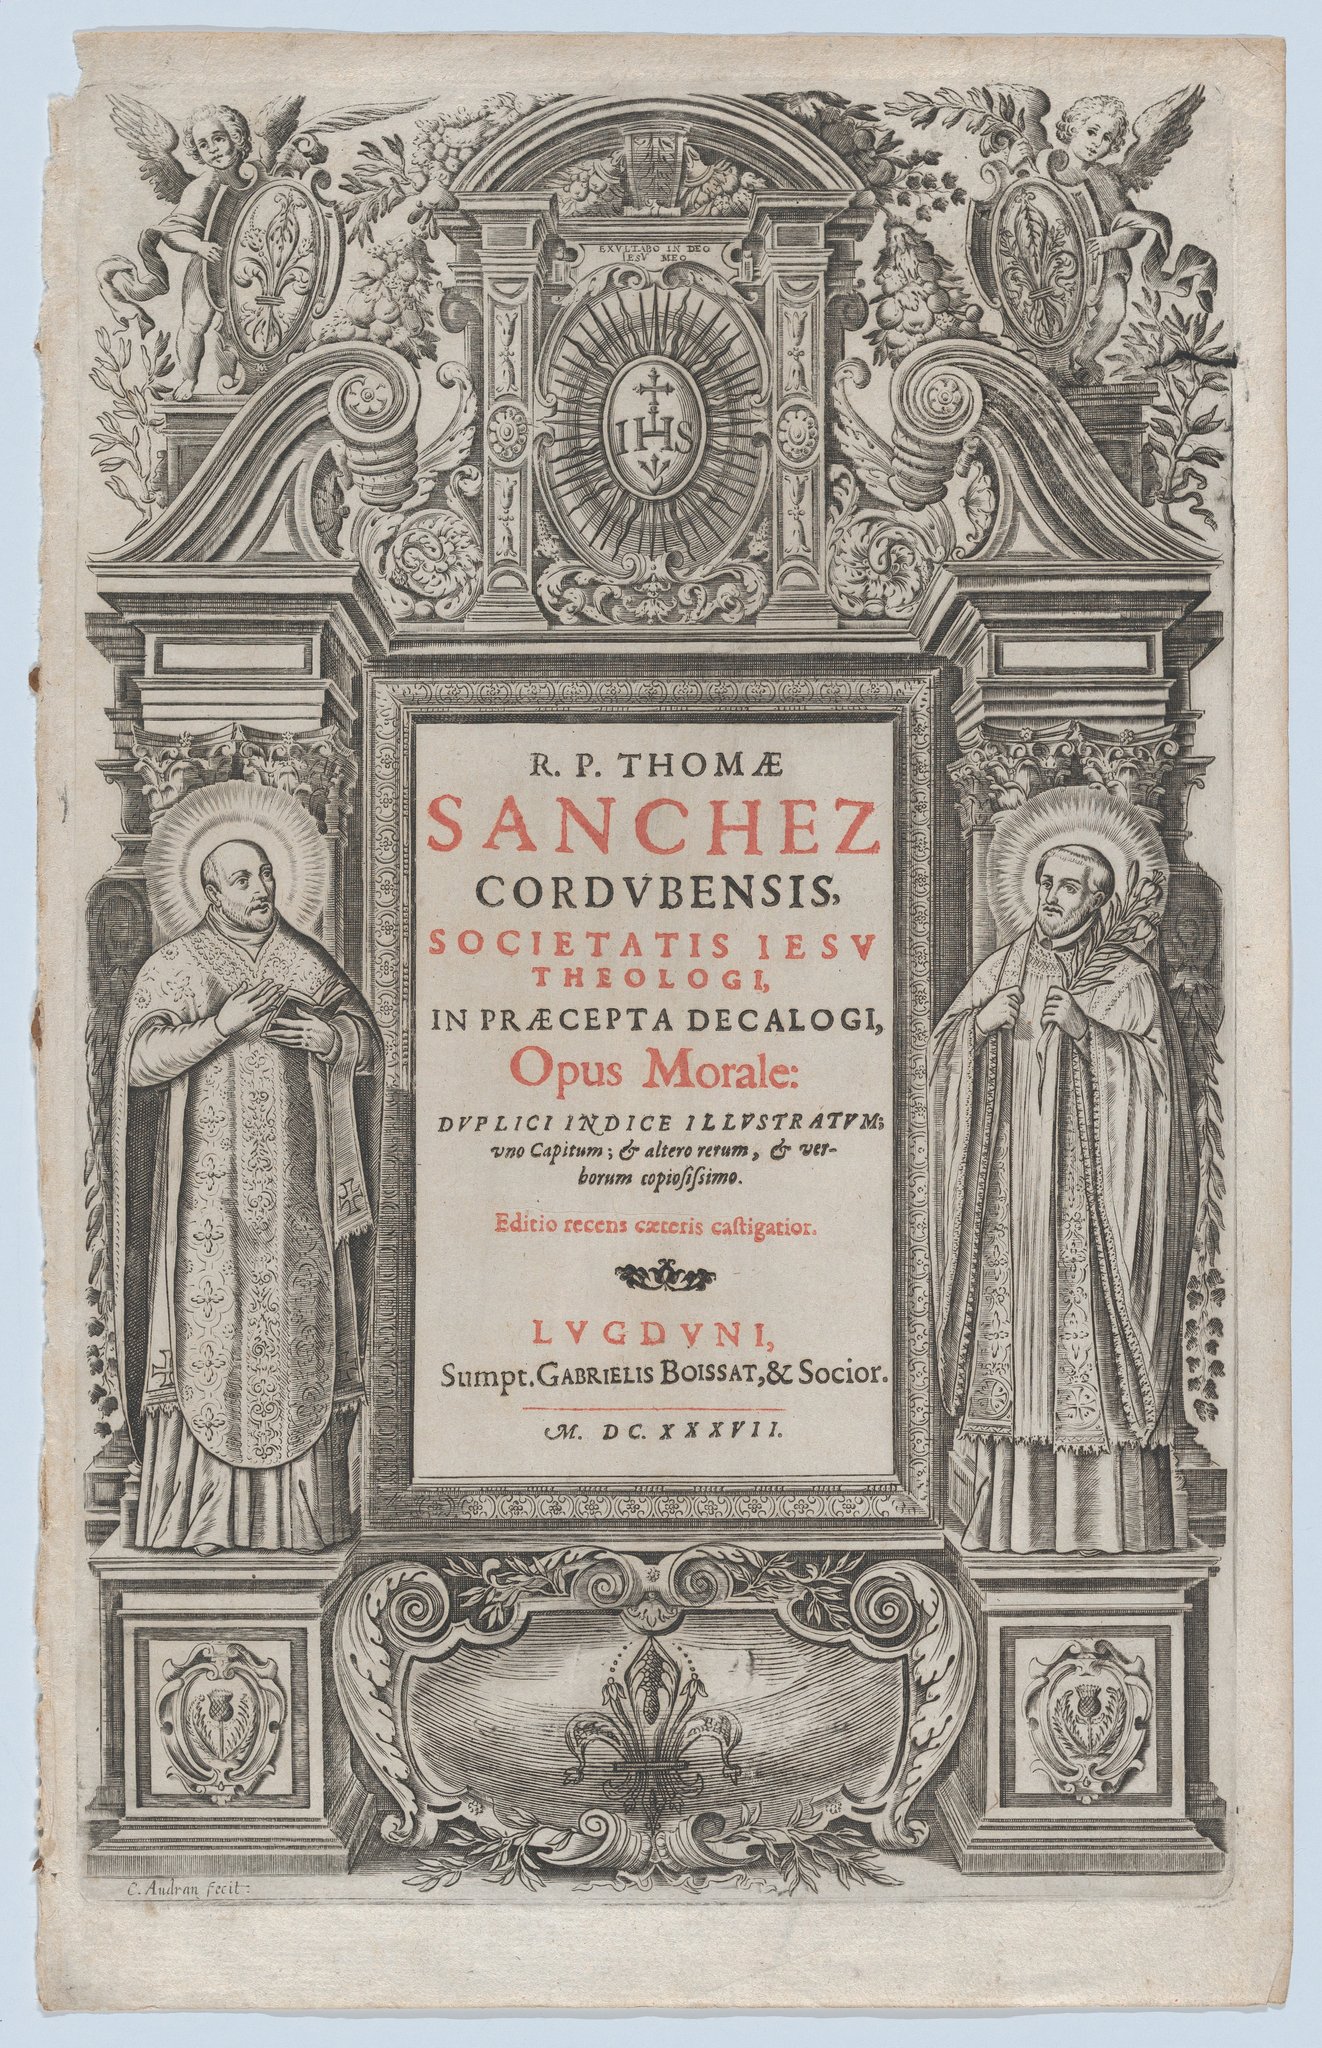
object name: print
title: Frontispiece for 'Opus morale in praecepta Decalogi'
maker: charles audran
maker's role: artist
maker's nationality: french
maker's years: 1594-1674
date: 1637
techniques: etching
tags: men,angels,saints